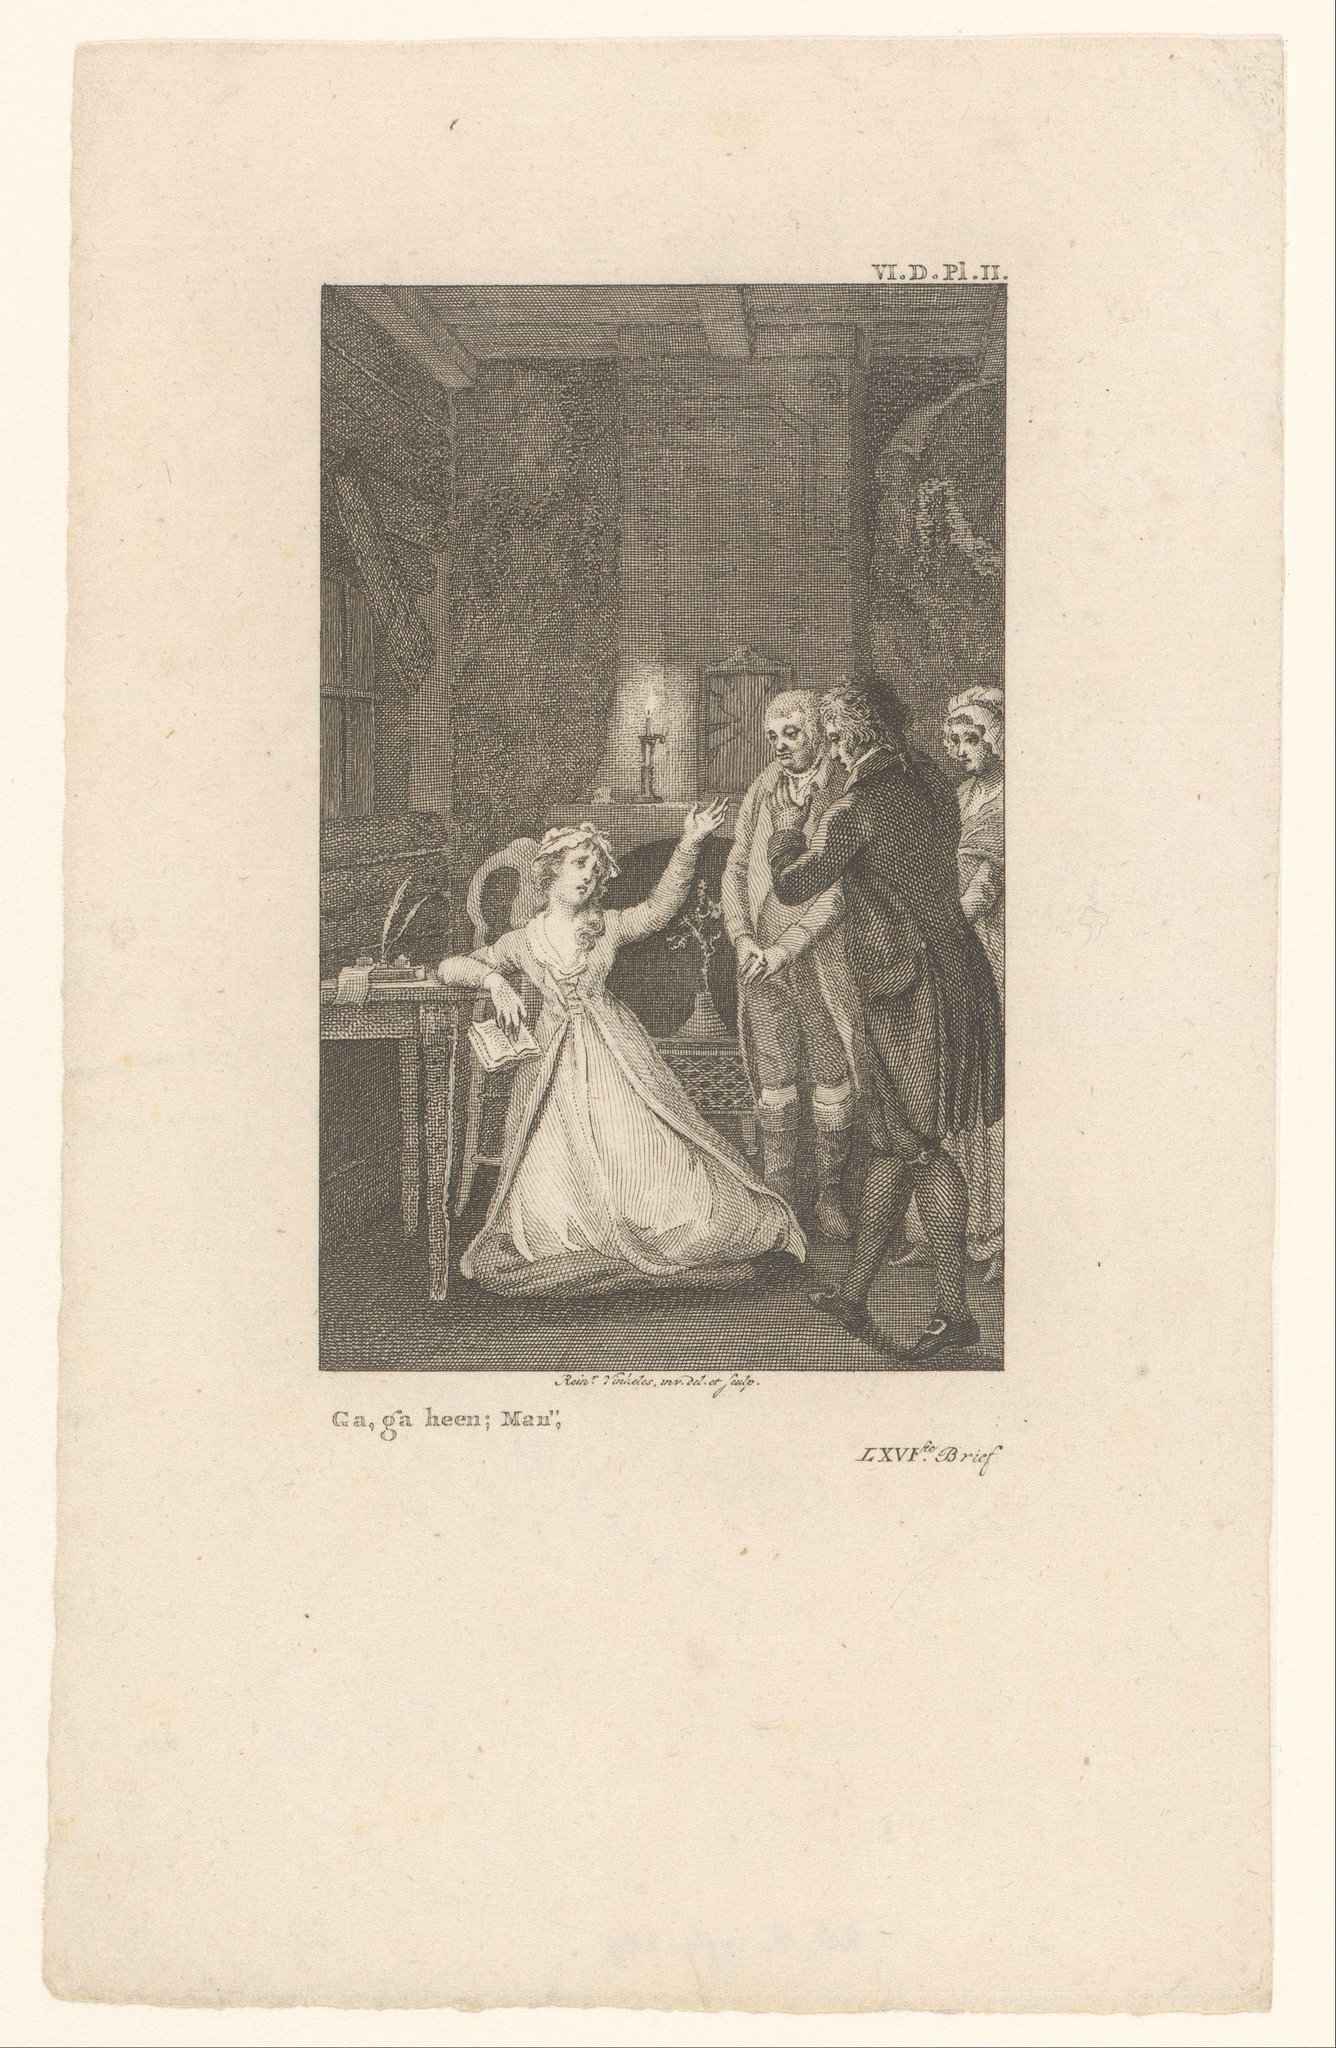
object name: book illustration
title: Clarissa vraagt John Belford te vertrekken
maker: reinier vinkeles (i)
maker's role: draughtsman, print maker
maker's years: 1741-1816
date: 1803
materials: paper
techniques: etching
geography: netherlands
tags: names of literary characters, arm raised upward, interior of the house, kneeling on both knees - aa - female human figure, female literary characters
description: Rechtsboven: VI. D. Pl. II. Rechtsonder: LXVIste. Brief. Interieur met vrouw die geknield steunt op een tafel. In haar ene hand houdt ze een boek en de andere hand houdt ze omhoog geheven. Voor haar twee mannen en een vrouw.